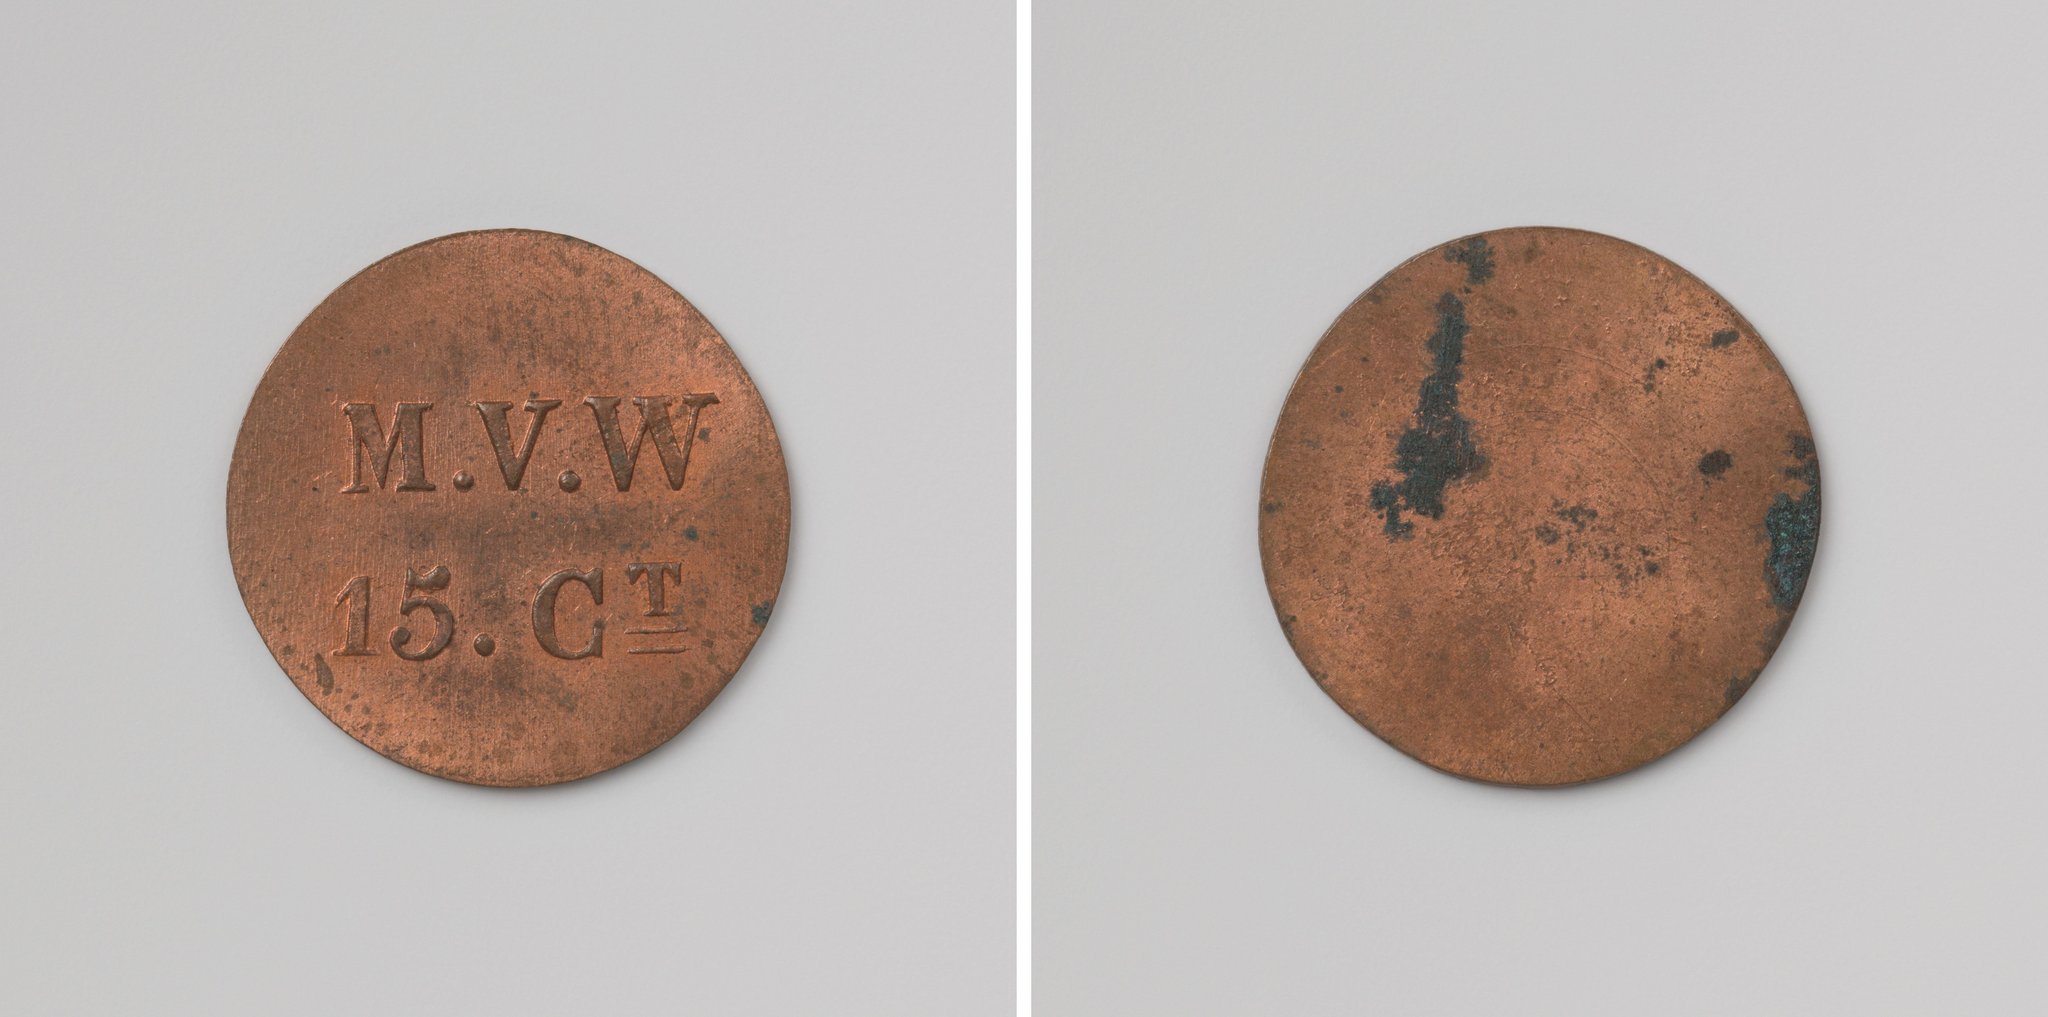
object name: monetary token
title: Huismunt geslagen op last van de Maatschappij van Weldadigheid ter waarde van vijftien cent, ten behoeve van de Gewone Koloniën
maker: Anonymous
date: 1818-1859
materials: copper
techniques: striking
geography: netherlands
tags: maatschappij van weldadigheid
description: eenzijdige munt. Voorzijde: opschrift boven waardeaanduiding. Keerzijde: blanco